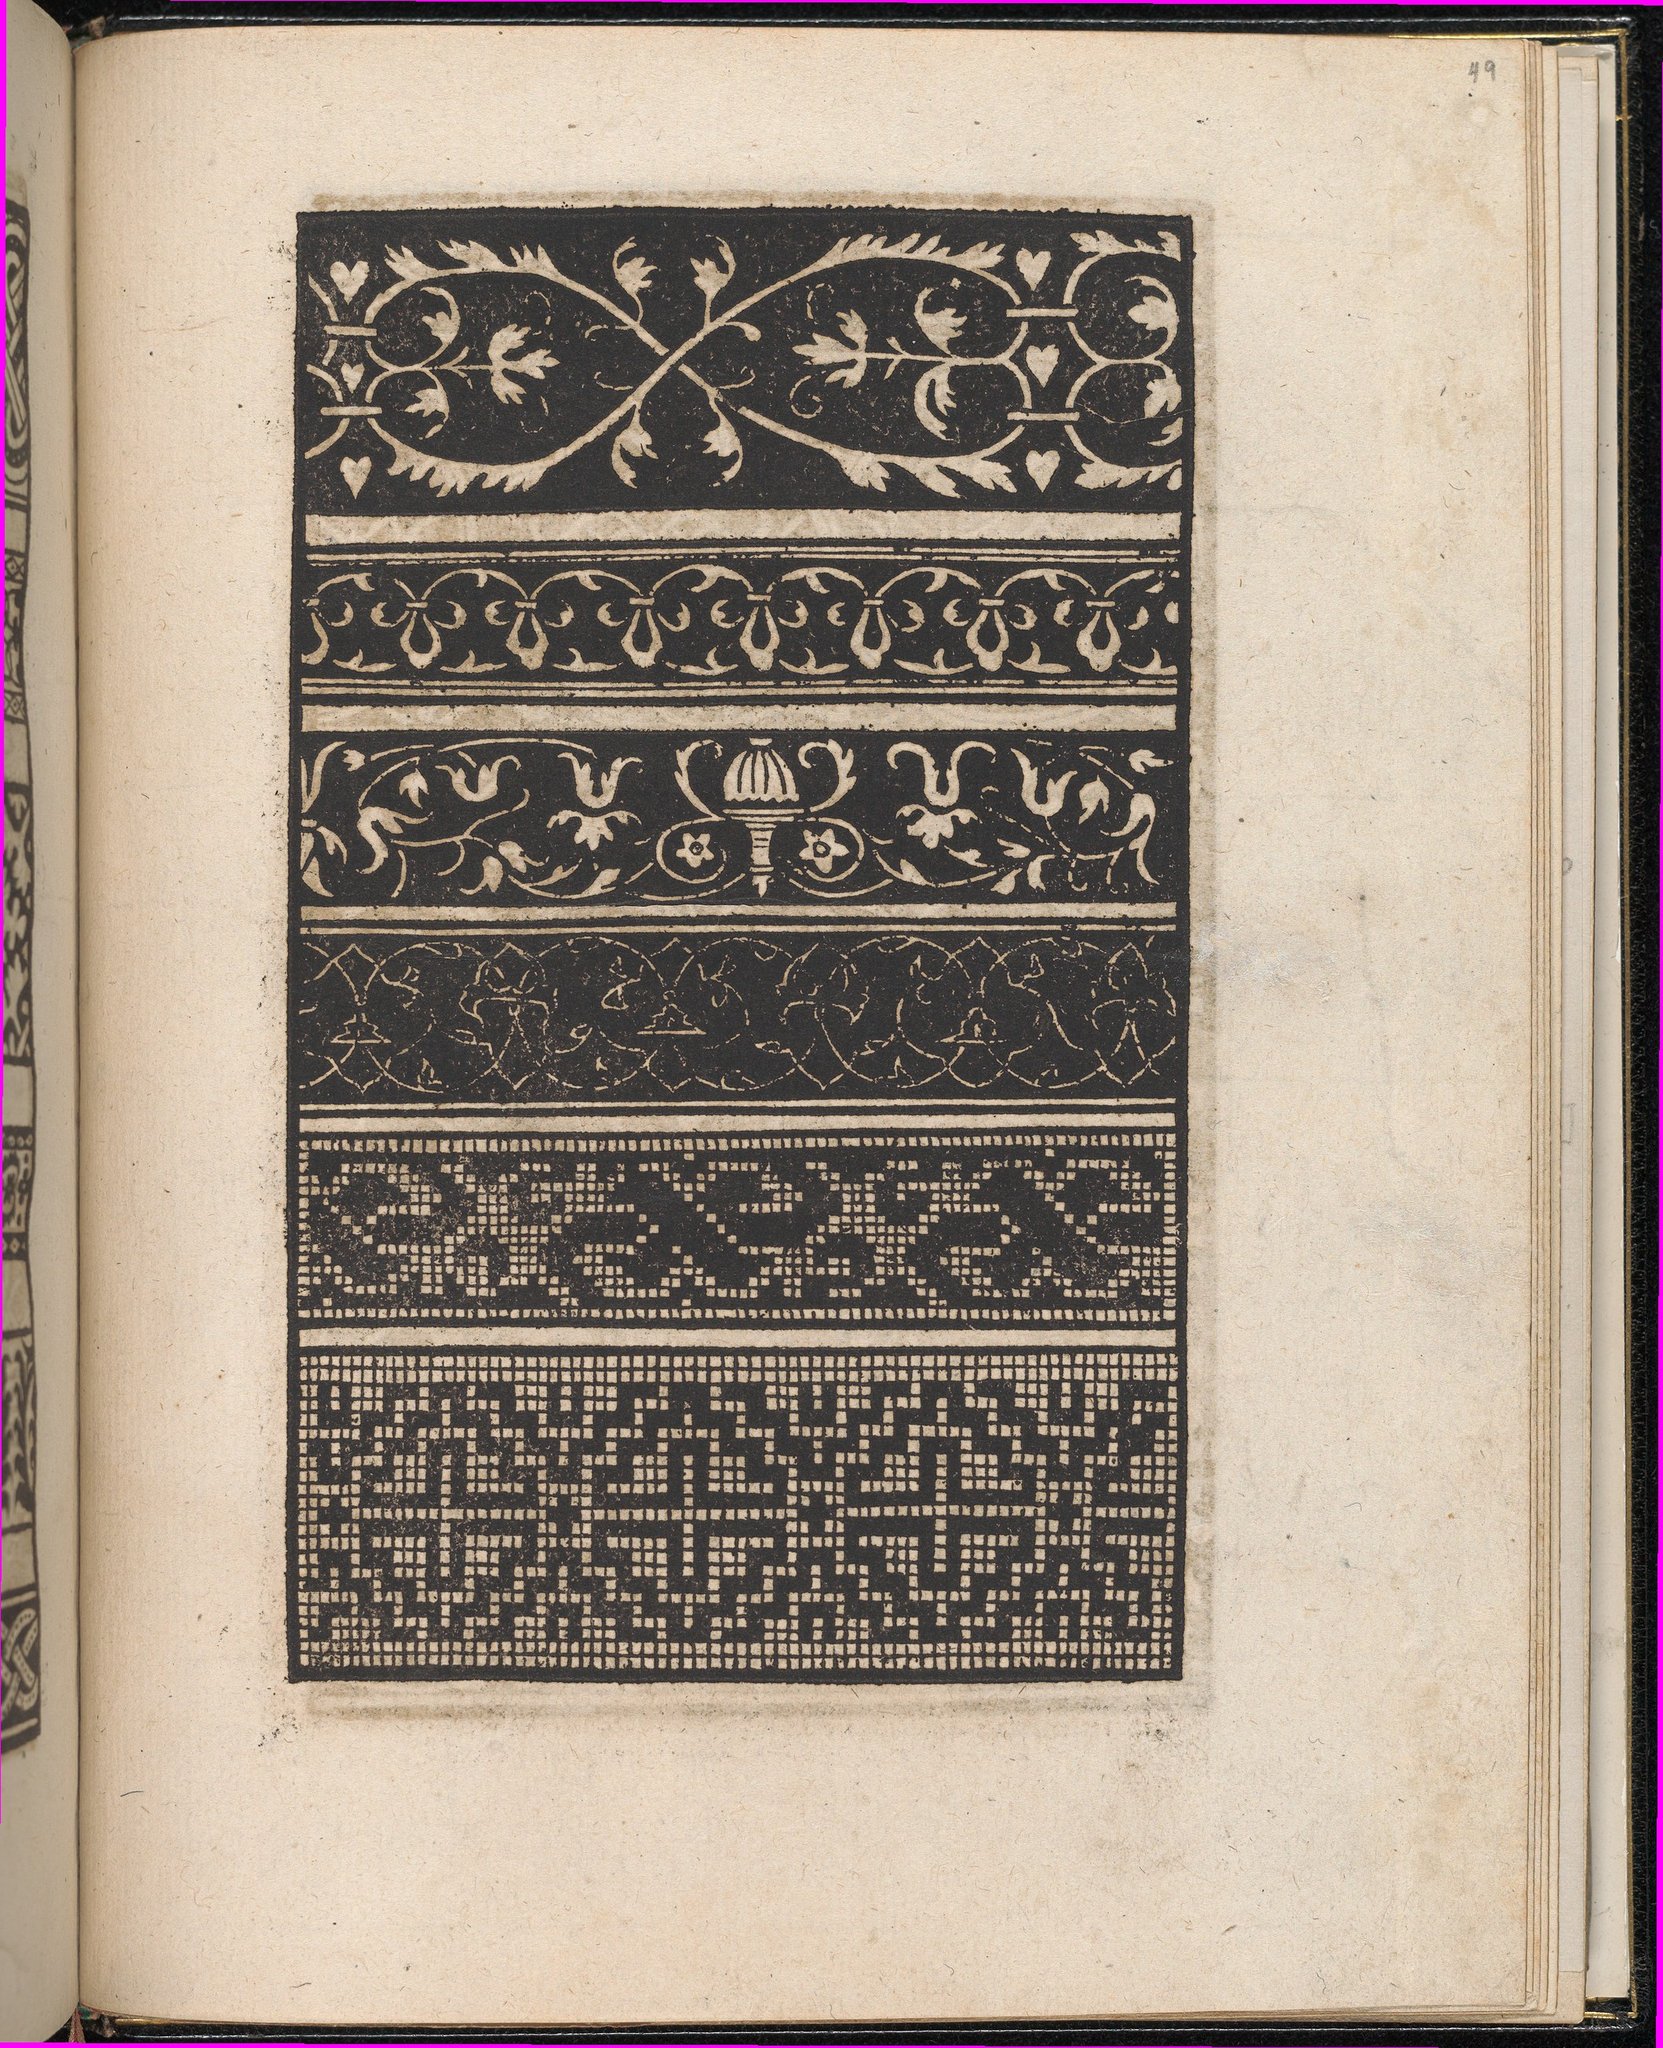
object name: book print ornament architecture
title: Page from Ein new kunstlich Modelbuch...(Page 49r)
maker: peter quentel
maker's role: publisher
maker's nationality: german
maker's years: 1500-1550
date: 1544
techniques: woodcut